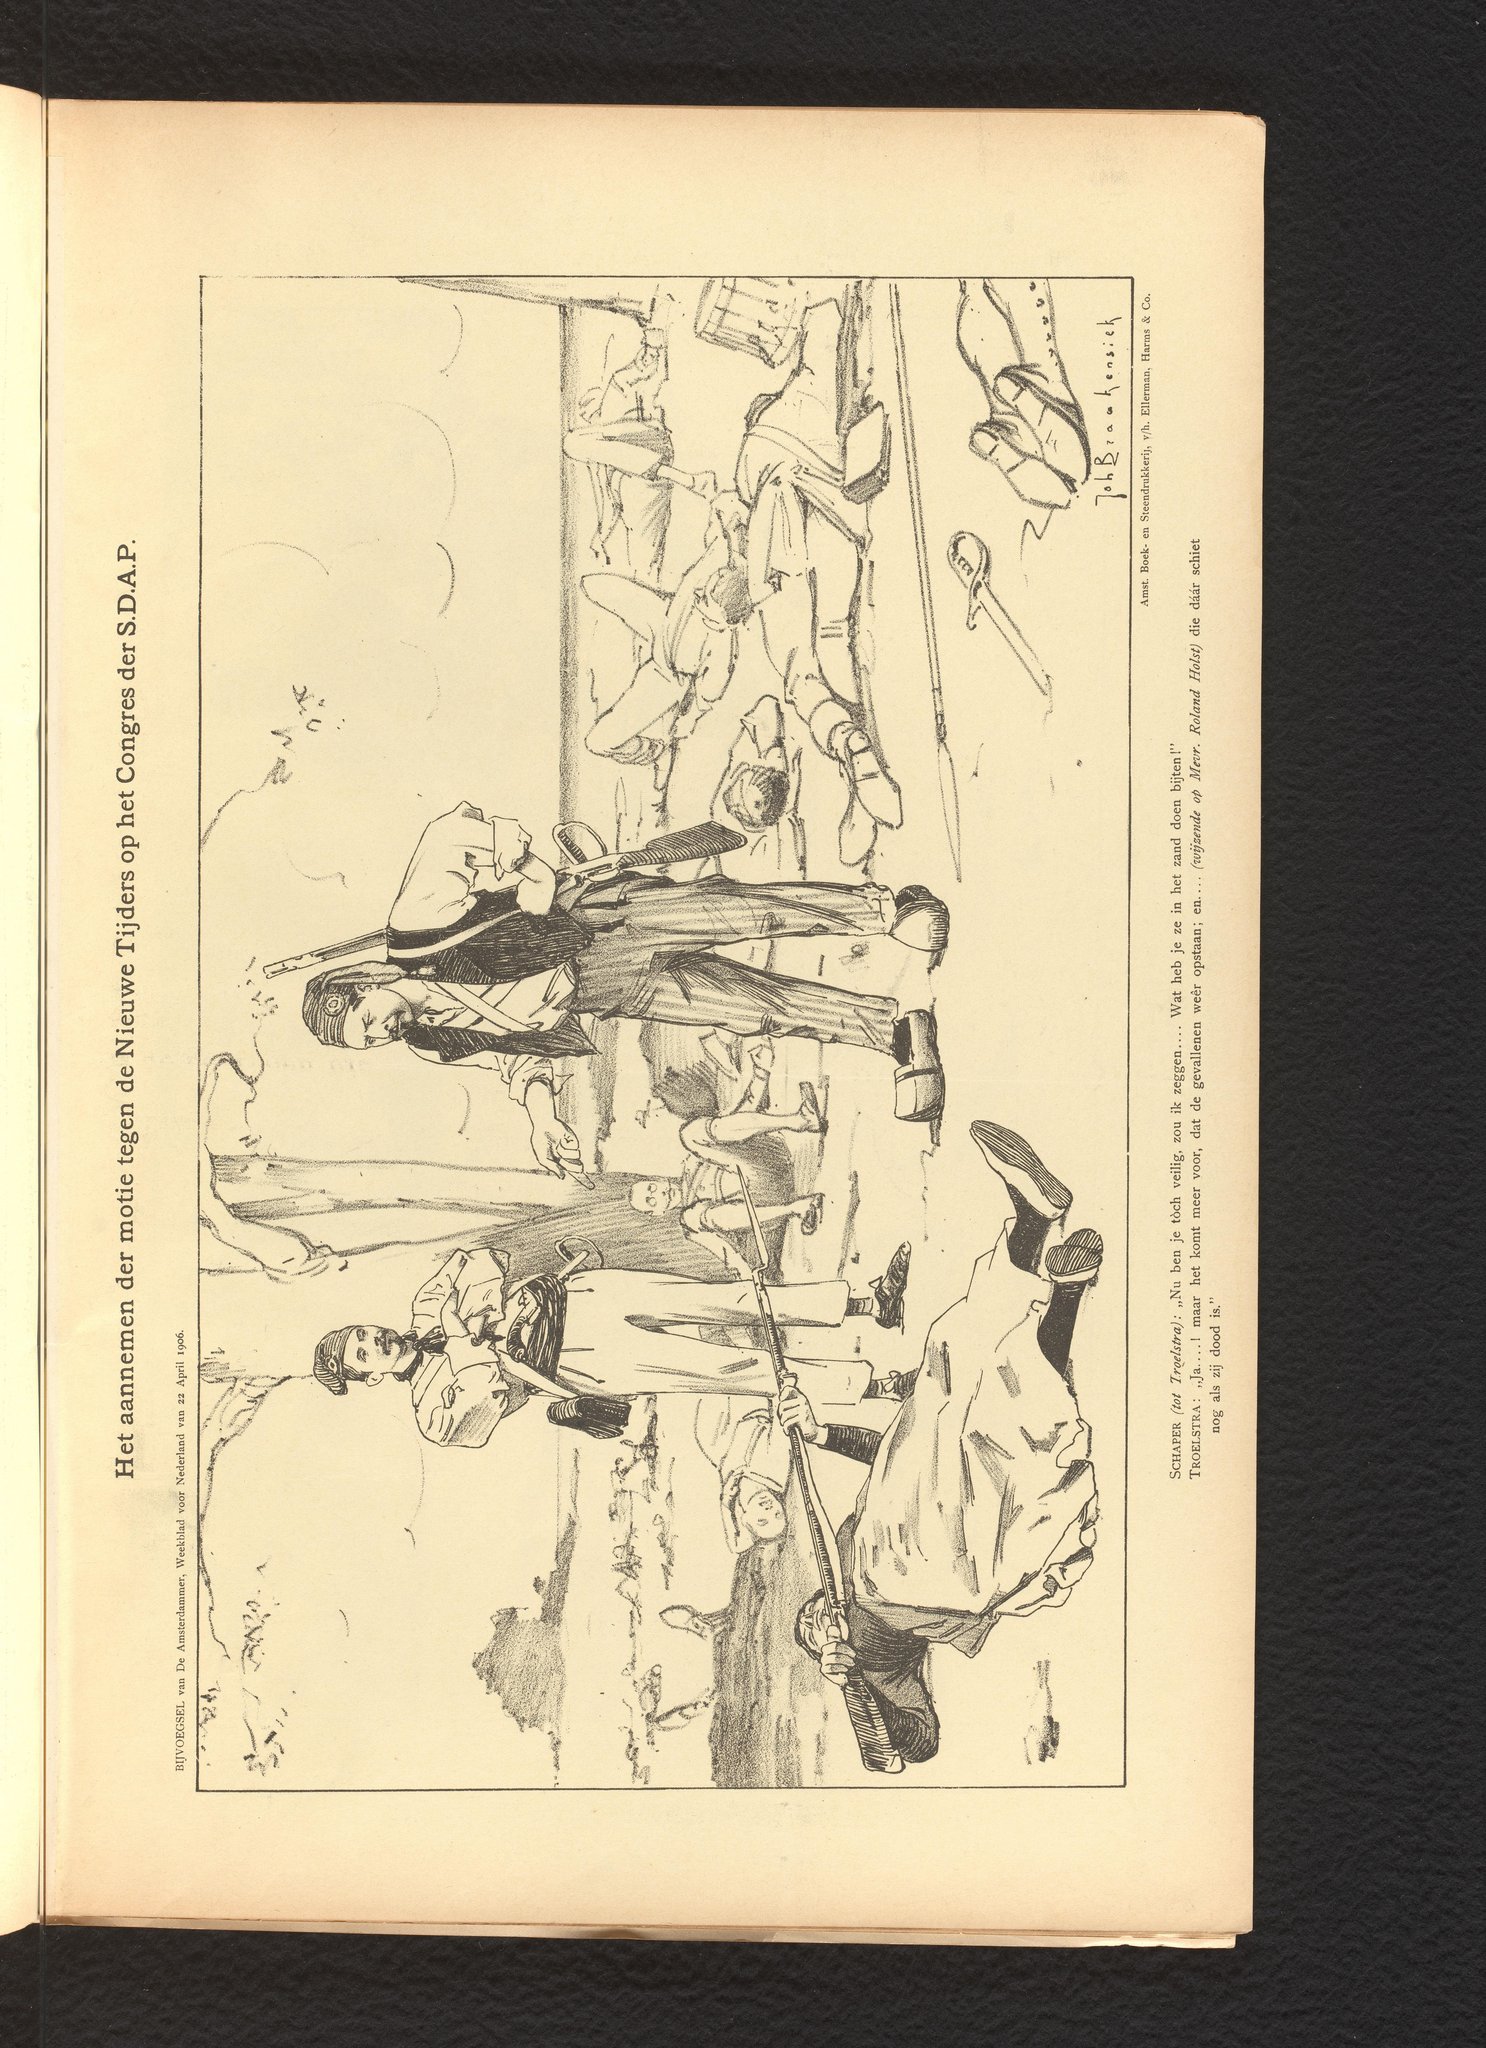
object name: cartoon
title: Het aannemen der motie tegen de Nieuwe Tijders op het Congres der S.D.A.P.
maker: johan braakensiek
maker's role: draughtsman, print maker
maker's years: 1858-1940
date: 1906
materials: paper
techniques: lithograph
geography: amsterdam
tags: politician, amsterdam, henriëtte roland holst-van der schalk, after the battle, political parties, political caricatures and satires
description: De partijleden Jan Schaper en Pieter Jelles Troelstra als partizanen op het slagveld bezaaid met de lichamen van hun tegenstanders, het partijcongres van de SDAP. Linksvoor het lichaam van Henriette Roland Holst-van der Schalk met geweer nog in de hand.